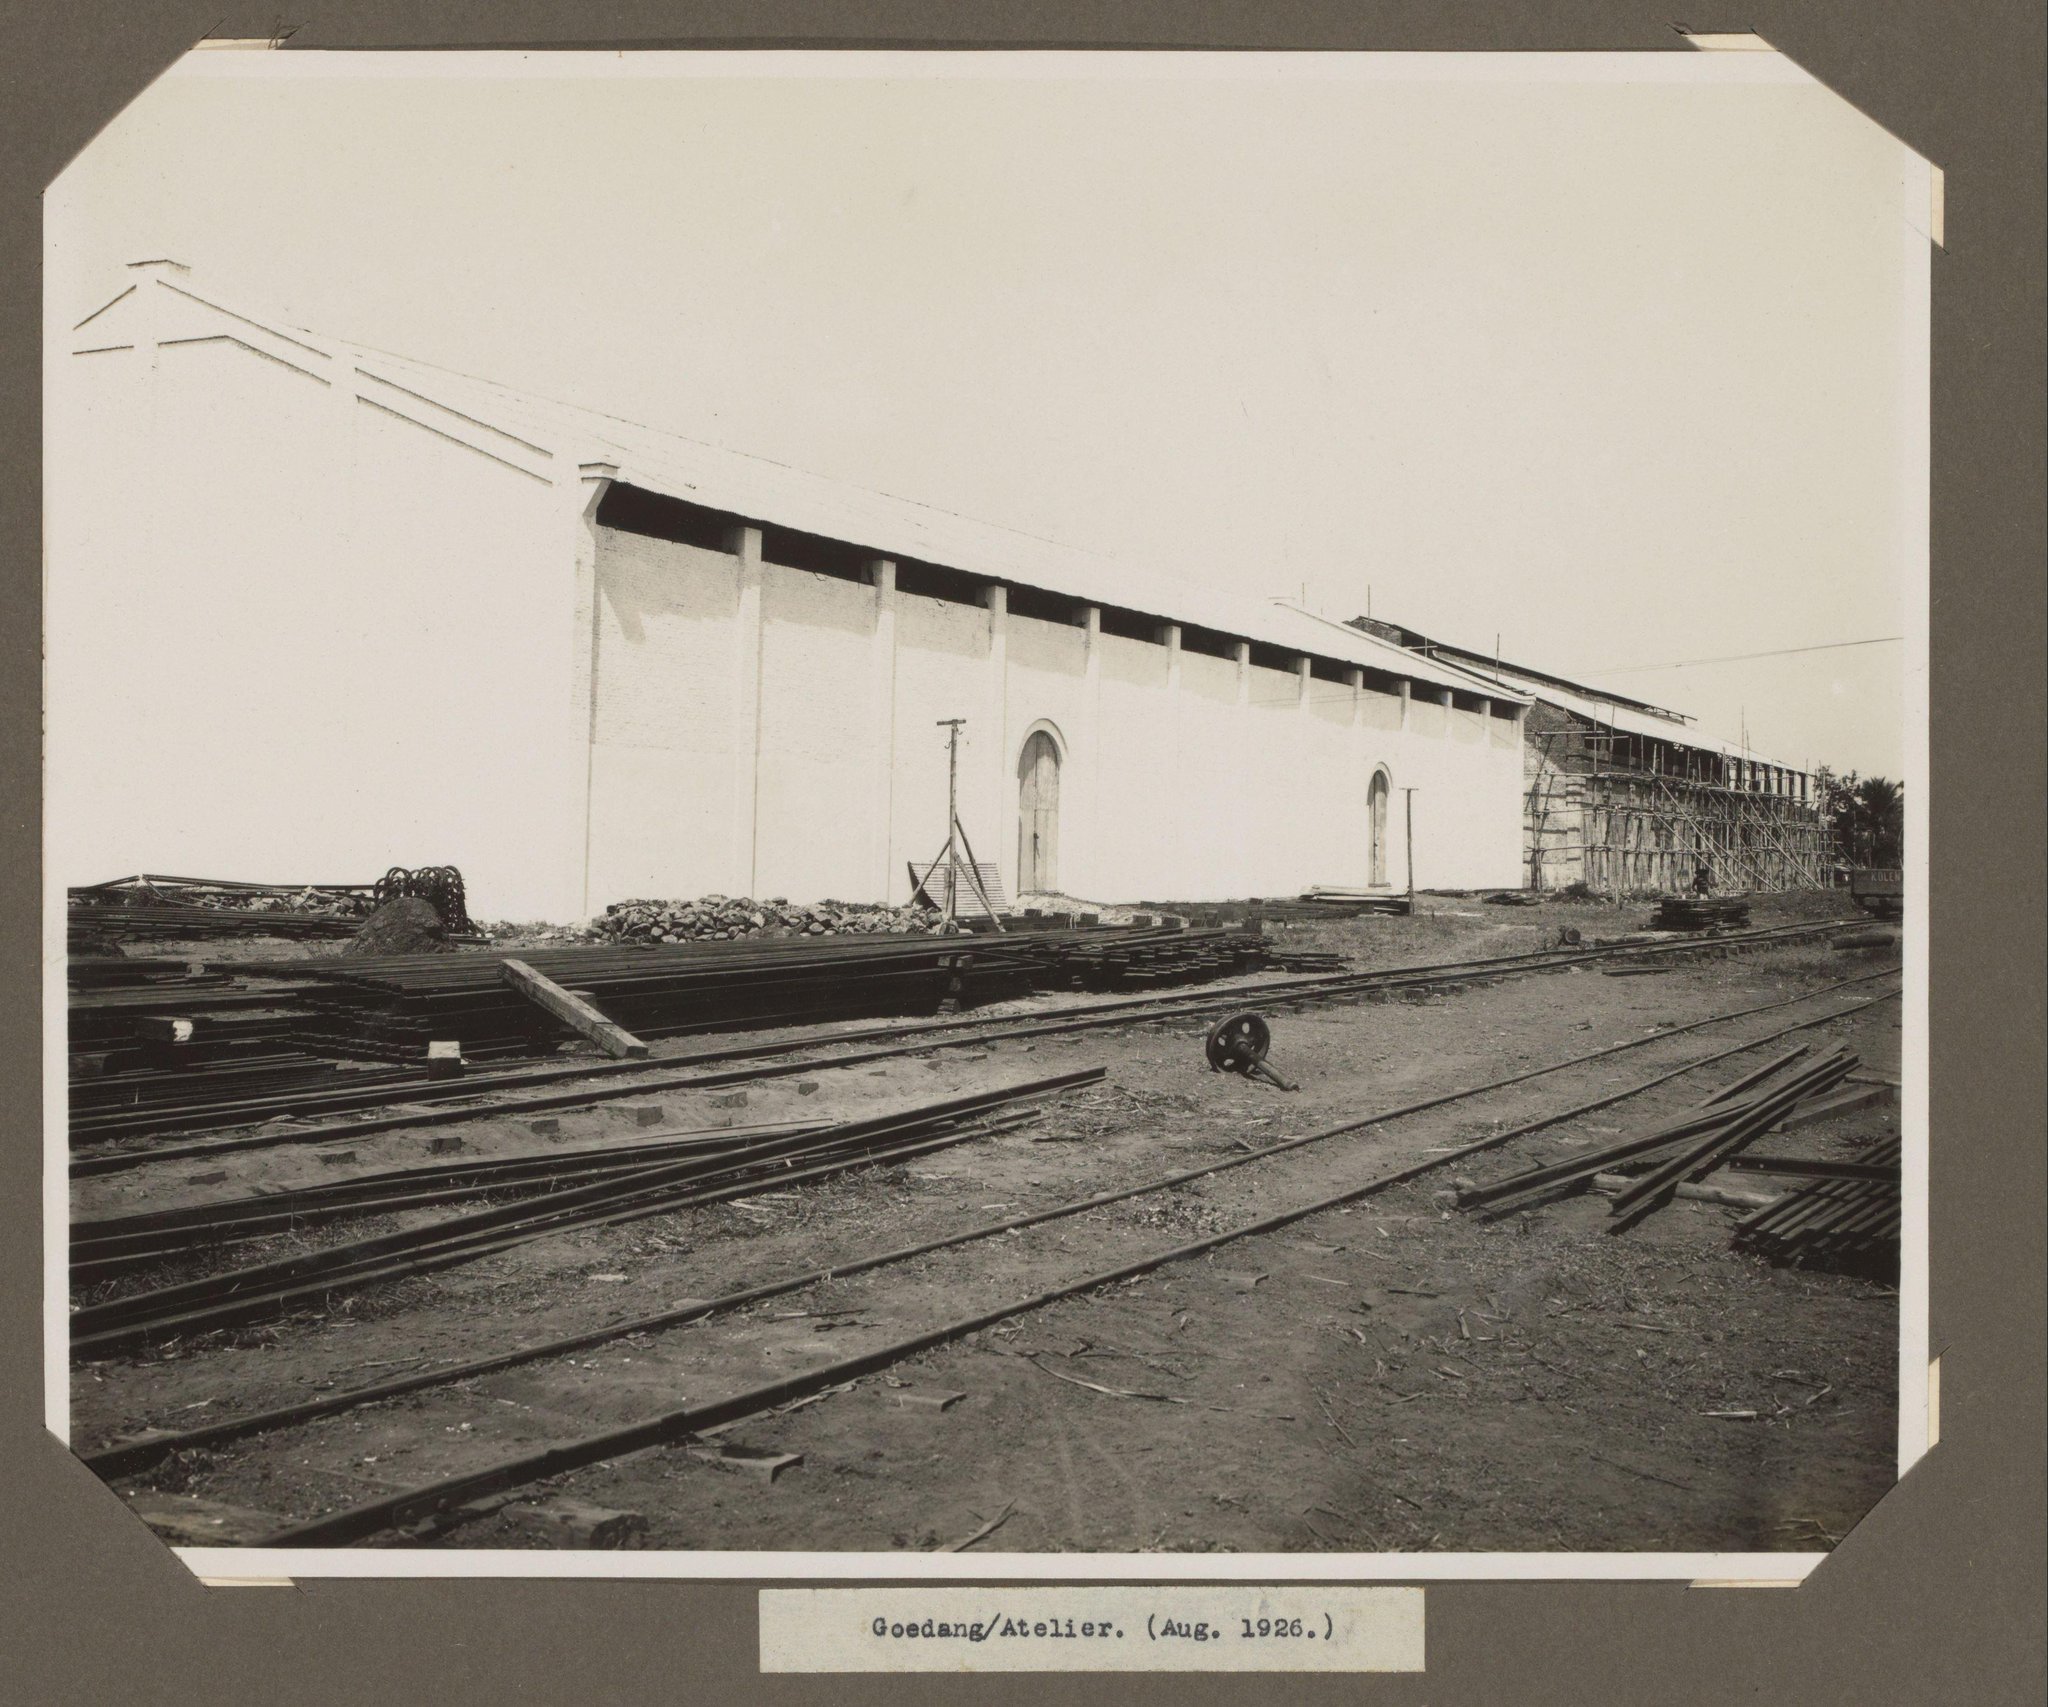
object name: photograph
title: Goedang/Atelier. (Aug. 1926.)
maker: Anonymous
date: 1908-1926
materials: photographic support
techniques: gelatin silver print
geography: east java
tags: colonial system, trade-company, making the overground structures (~ building activities), (non-fruit) products of plants or trees: sugarcane, exterior of industrial structures, factories, representation of real building (either existing or having existed)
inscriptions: inscription: ‘Goedang/Atelier. (Aug. 1926.)’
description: Bouw van de loods en atelier bij de fabriek, augustus 1926. Onderdeel van het fotoalbum met foto's van de opbouw van de suikerfabriek te Goenoengsari op Oost-Java door de Handels Vereniging Amsterdam 1926-1927.